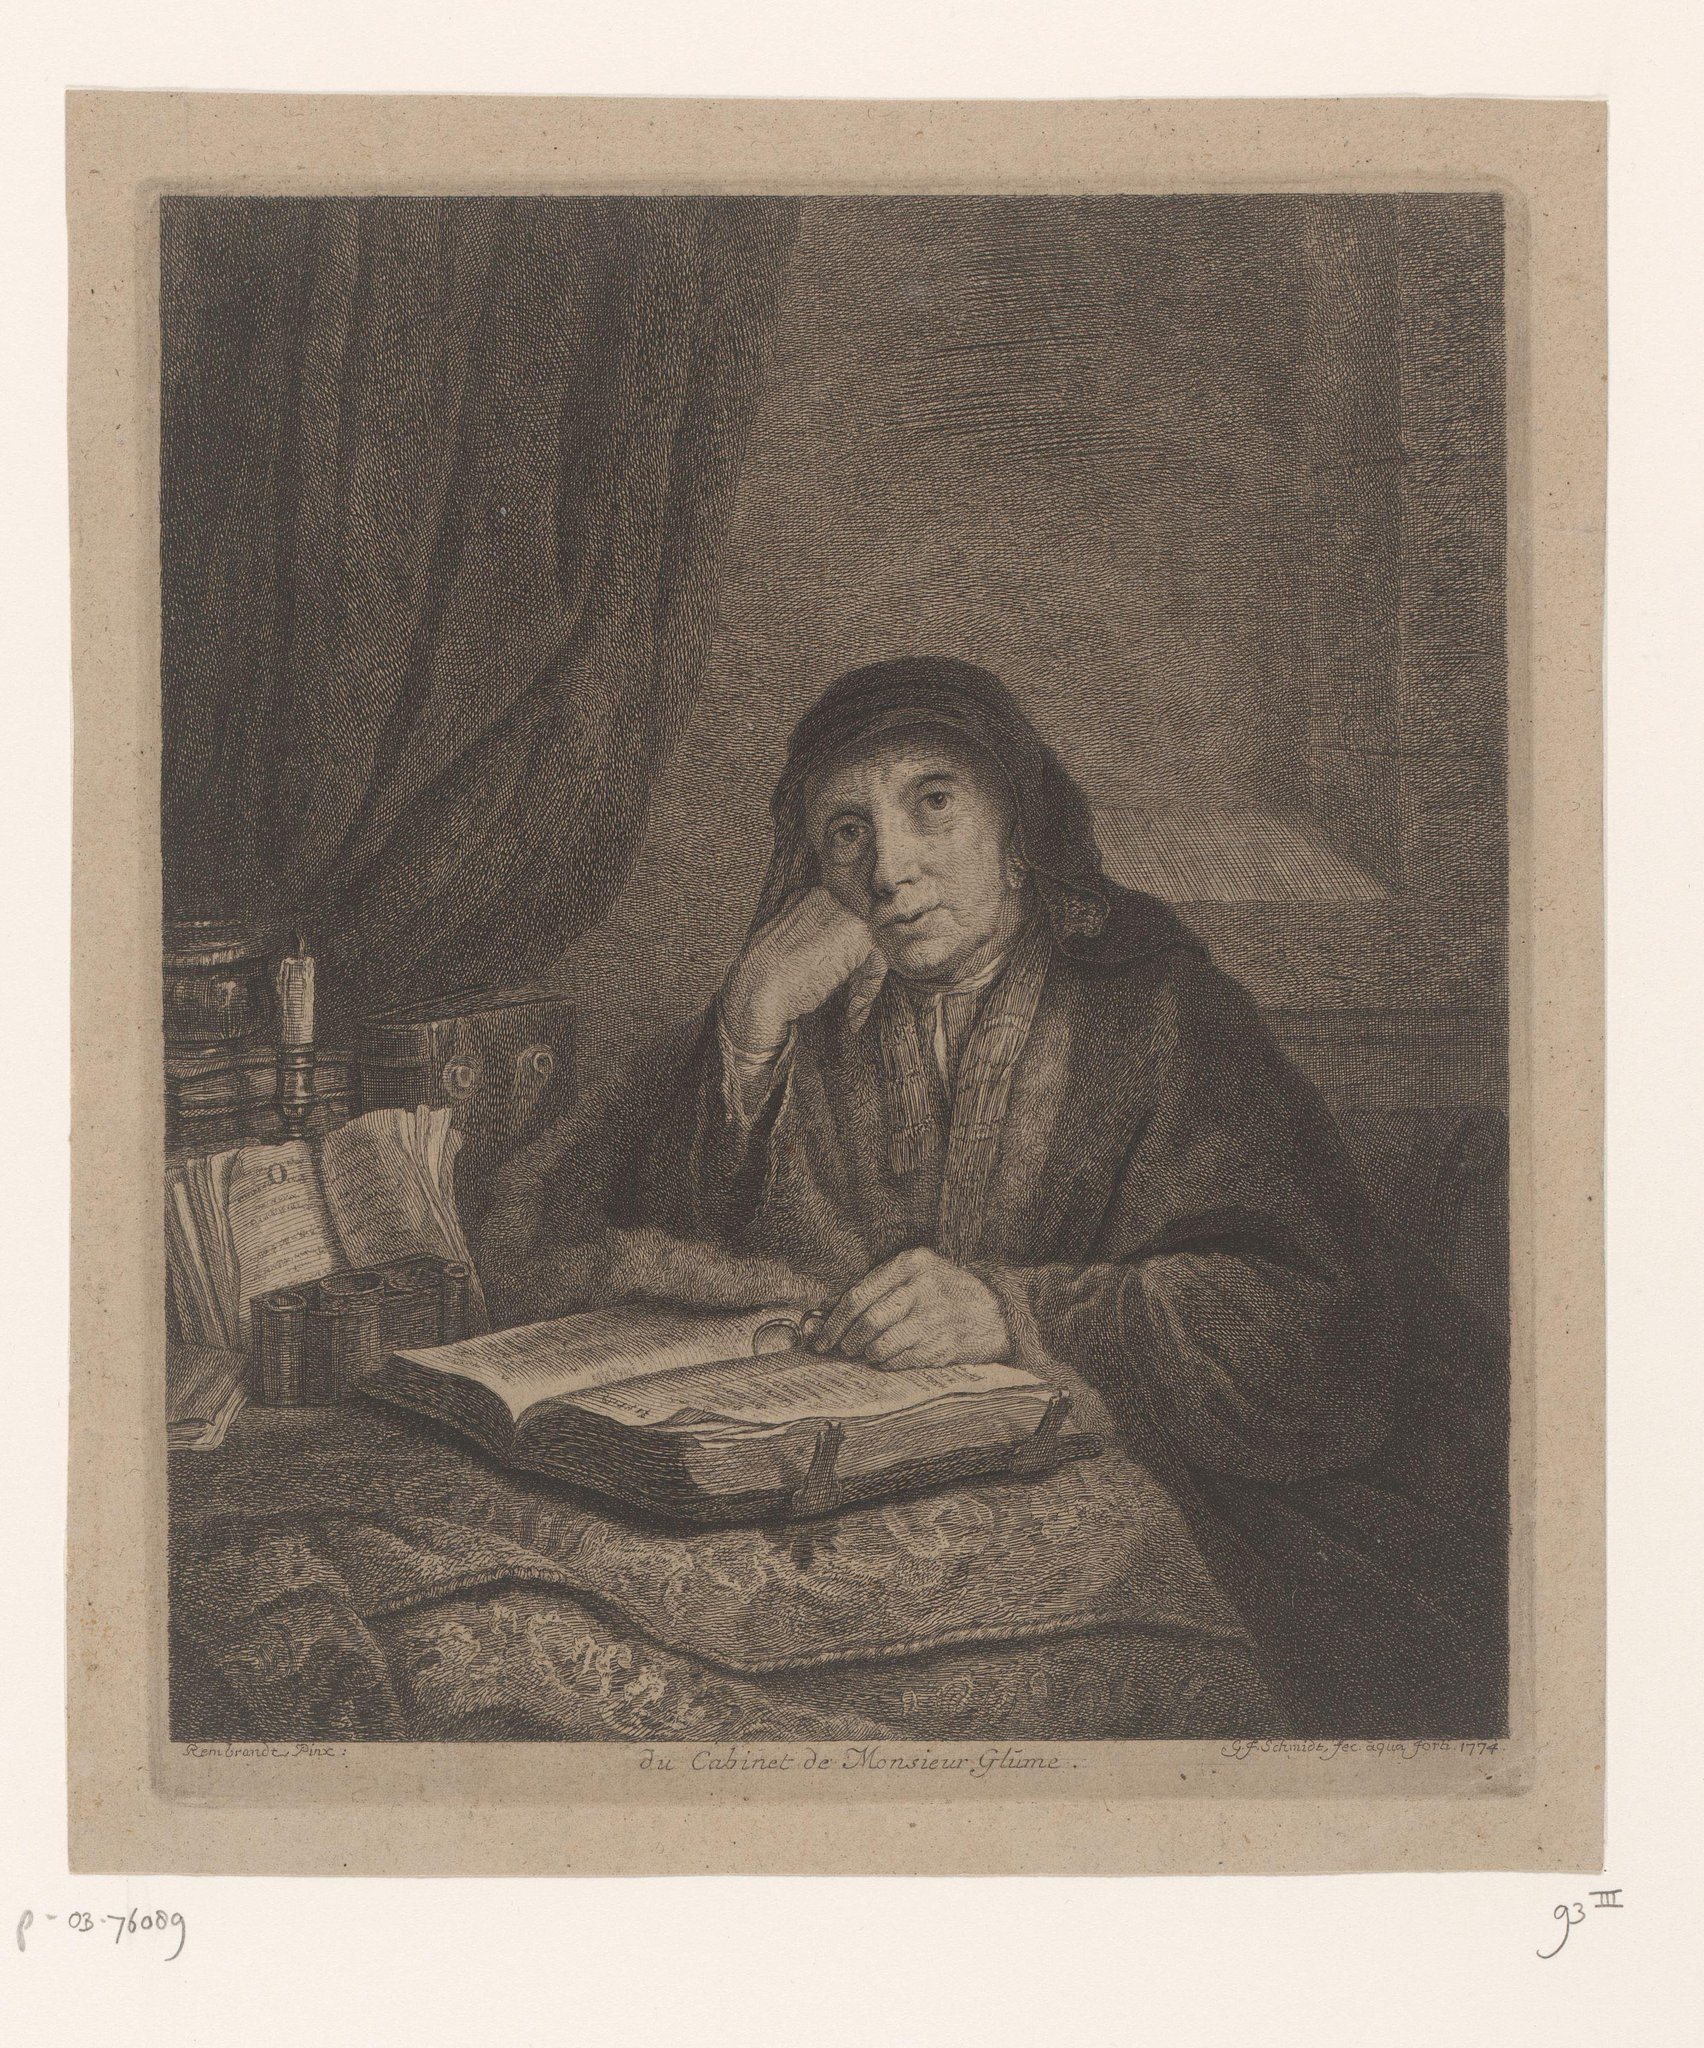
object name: print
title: Portret van Neeltje Willemsdr. Zuytbrouck lezend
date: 1774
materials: paper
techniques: etching, intaglio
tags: historical persons - bb - woman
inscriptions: collector's mark: Lugt 240